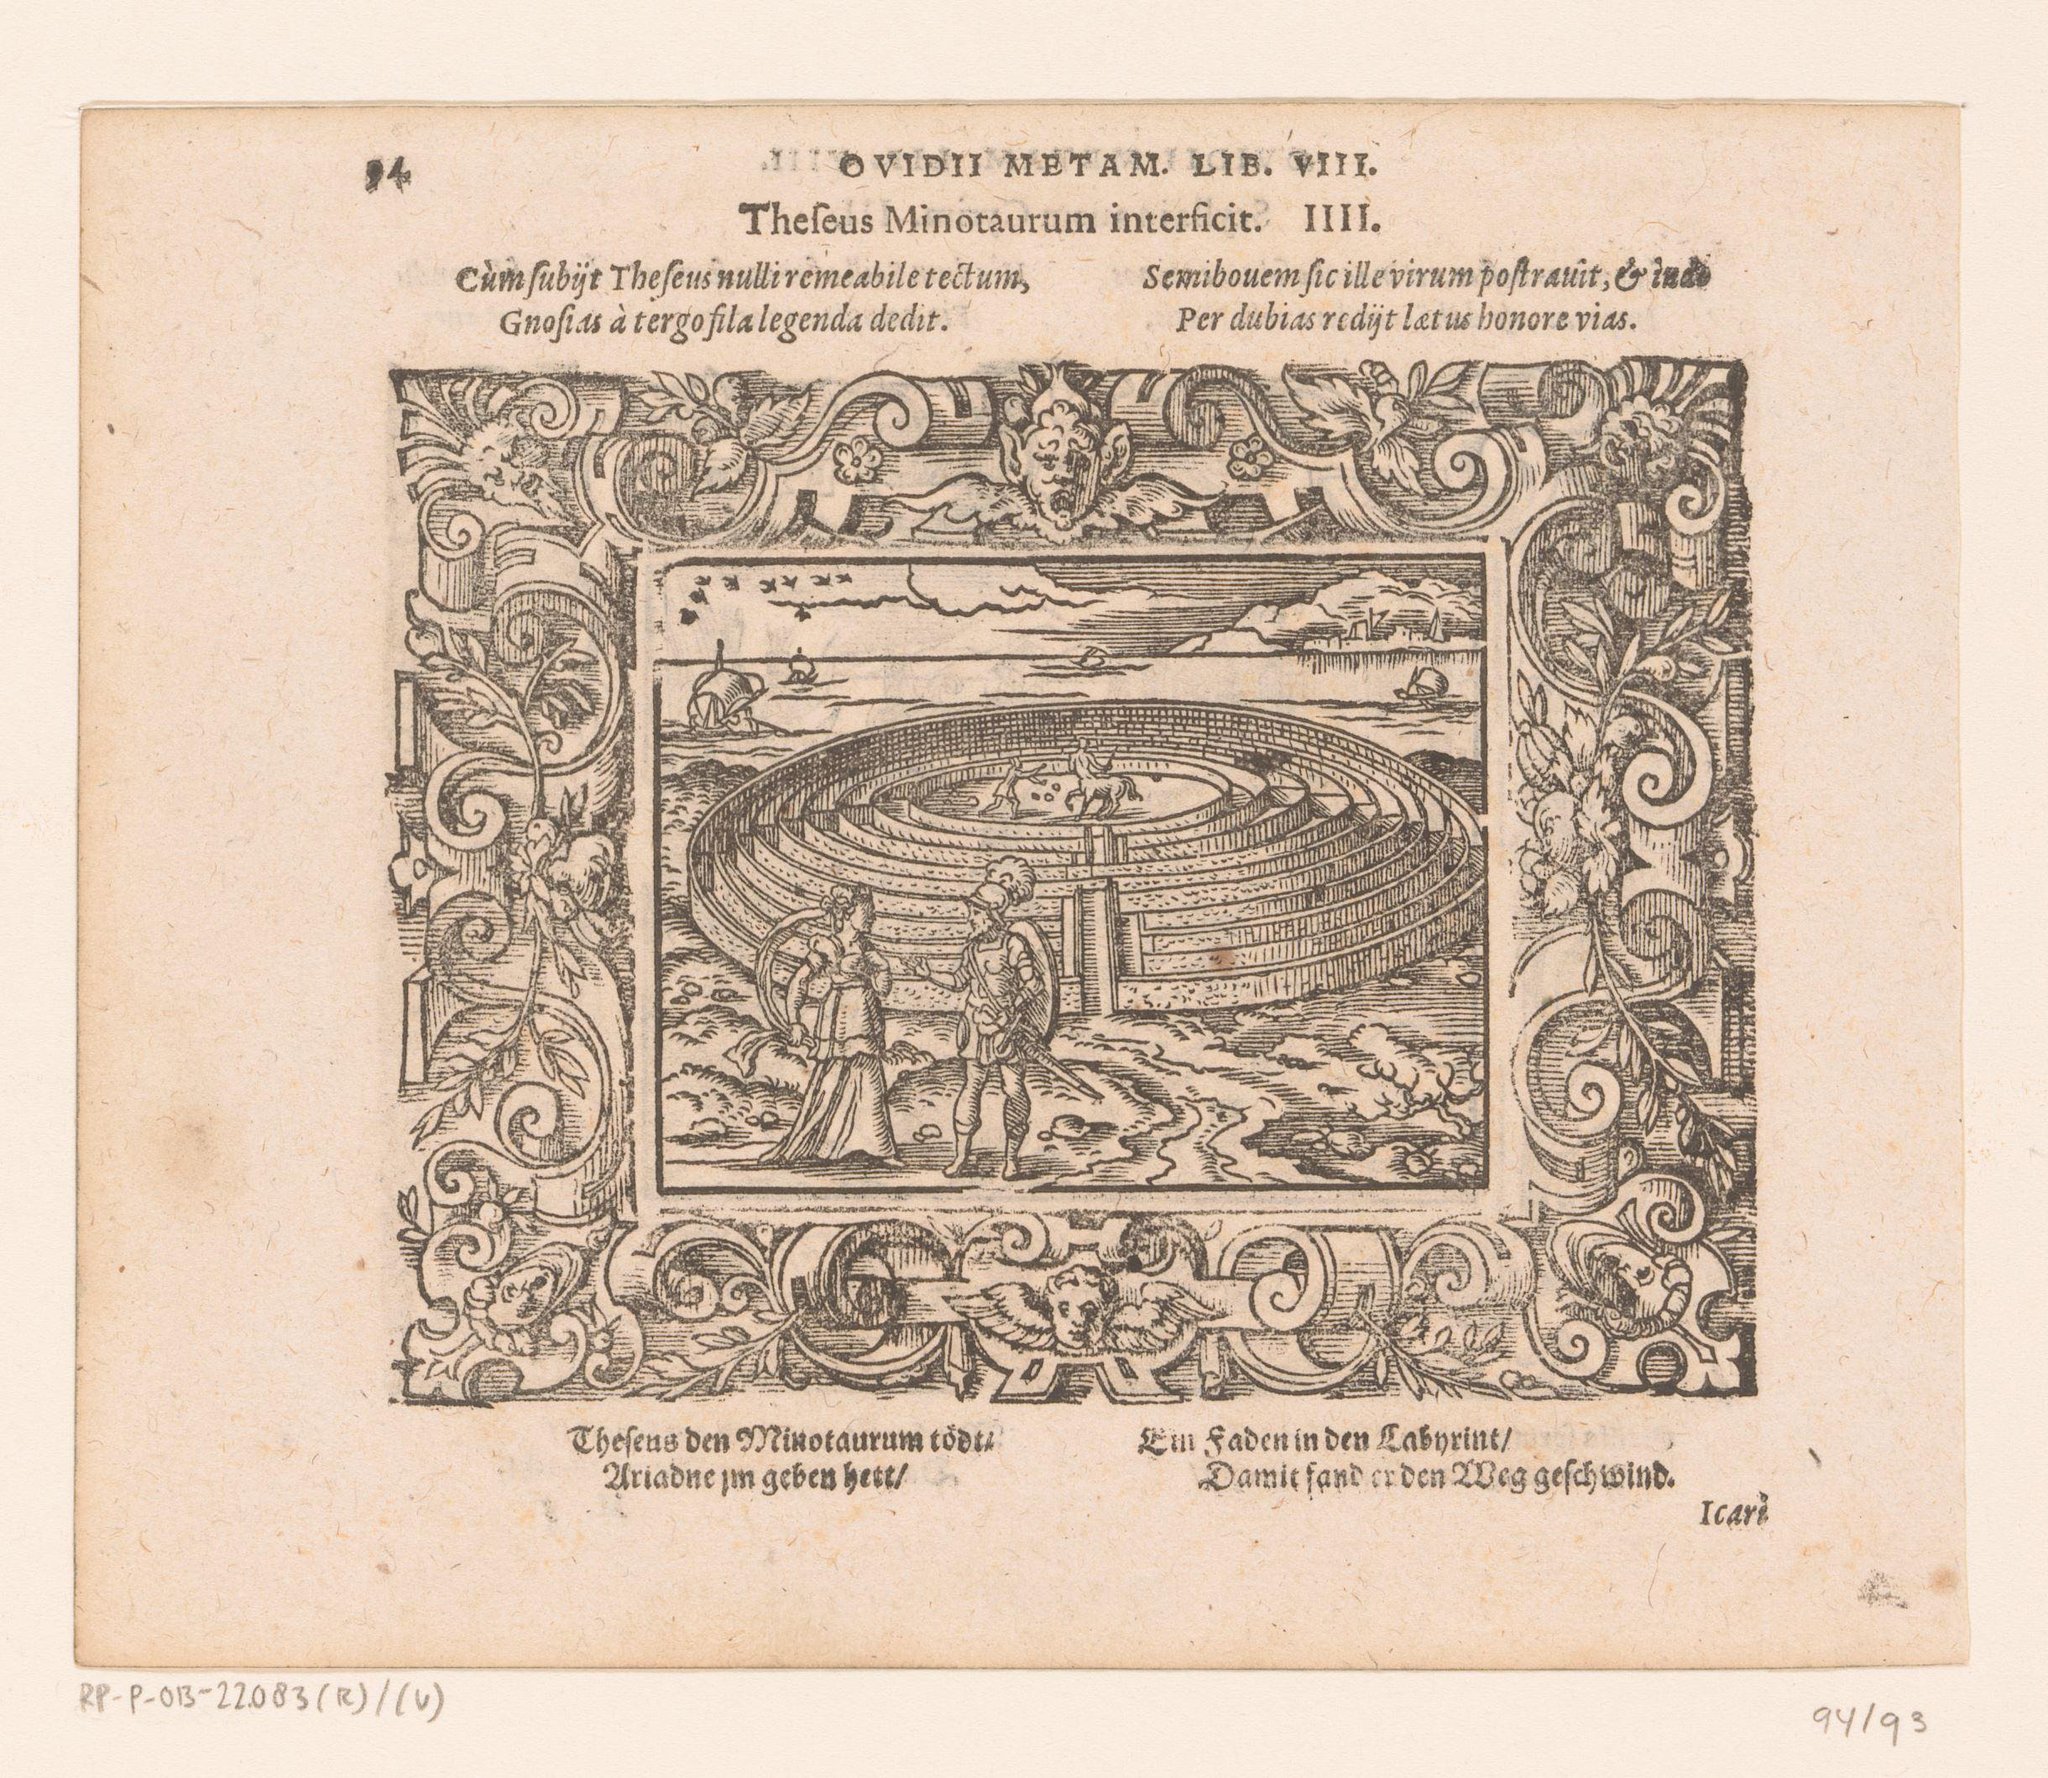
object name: book illustration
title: Theseus Minotaurum interficit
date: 1569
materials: paper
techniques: letterpress printing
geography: frankfurt am main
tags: ariadne gives theseus a ball of thread, scrollwork, strapwork ~ ornament, the minotaur, half a man and half a bull, in his dwelling-place, the labyrinth, supplied with human sacrifices, most important deeds: theseus and the minotaur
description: Illustratie bij de Metamorfosen van Ovidius, afkomstig uit de publicatie: Posthius, Johannes. Tetrasticha in Ovidii metam. Frankfurt am Main: Georg Rab en Sigmund Feyerabend en erven Weigand Han, 1569. De voorstellingen en ornamentranden van deze boekillustraties zijn van twee aparte blokken gedrukt. Beide werden afzonderlijk van elkaar ook gebruikt voor andere publicaties, en de ornamentranden werden eveneens binnen deze publicatie meerdere keren gebruikt.